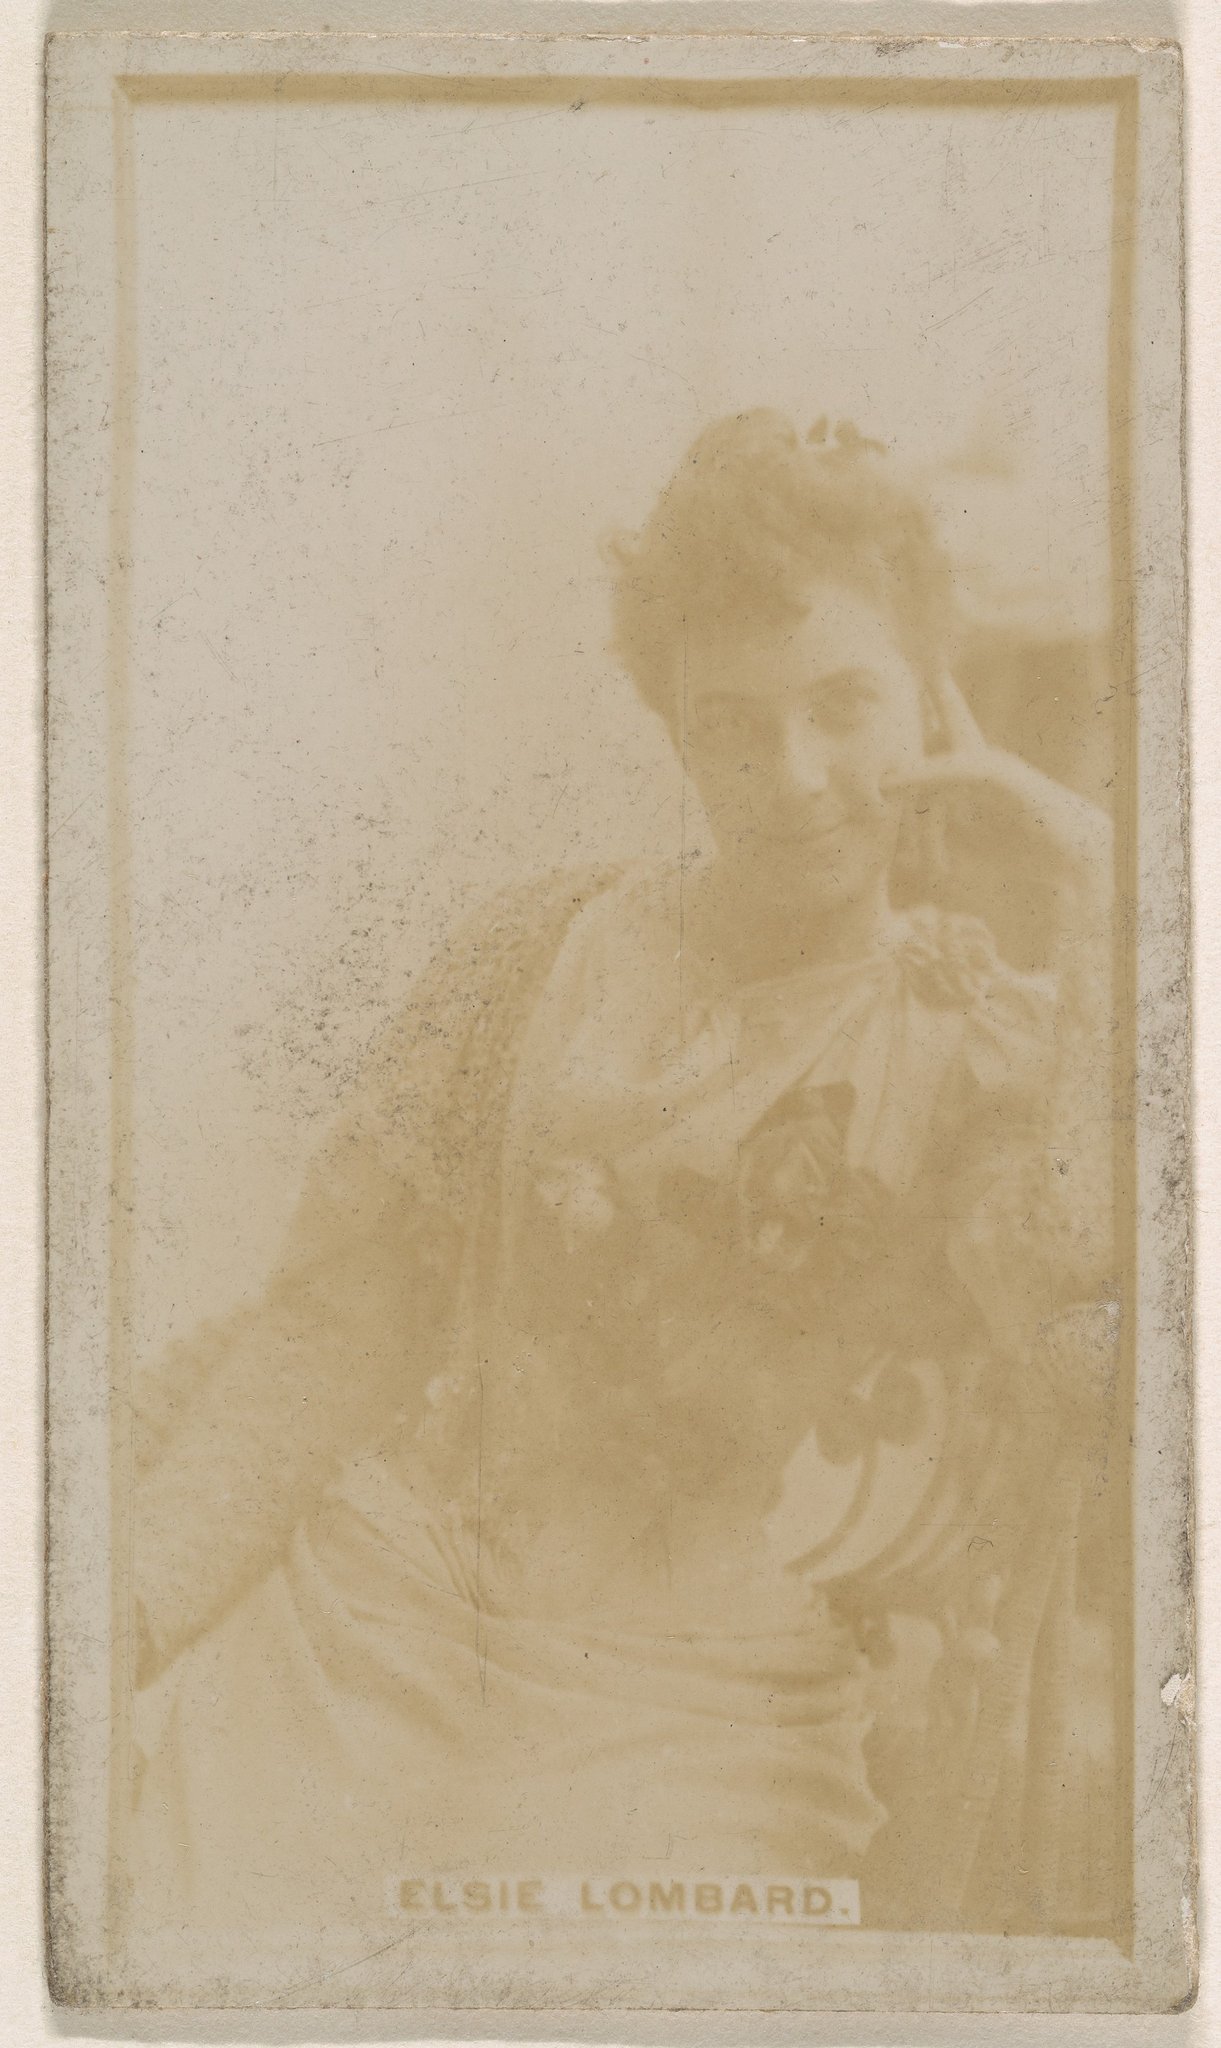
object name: photograph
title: Elsie Lombard, from the Actresses series (N245) issued by Kinney Brothers to promote Sweet Caporal Cigarettes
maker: kinney brothers tobacco company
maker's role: publisher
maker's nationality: american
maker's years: 1869-2011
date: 1890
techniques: albumen silver print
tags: portraits,women,actresses